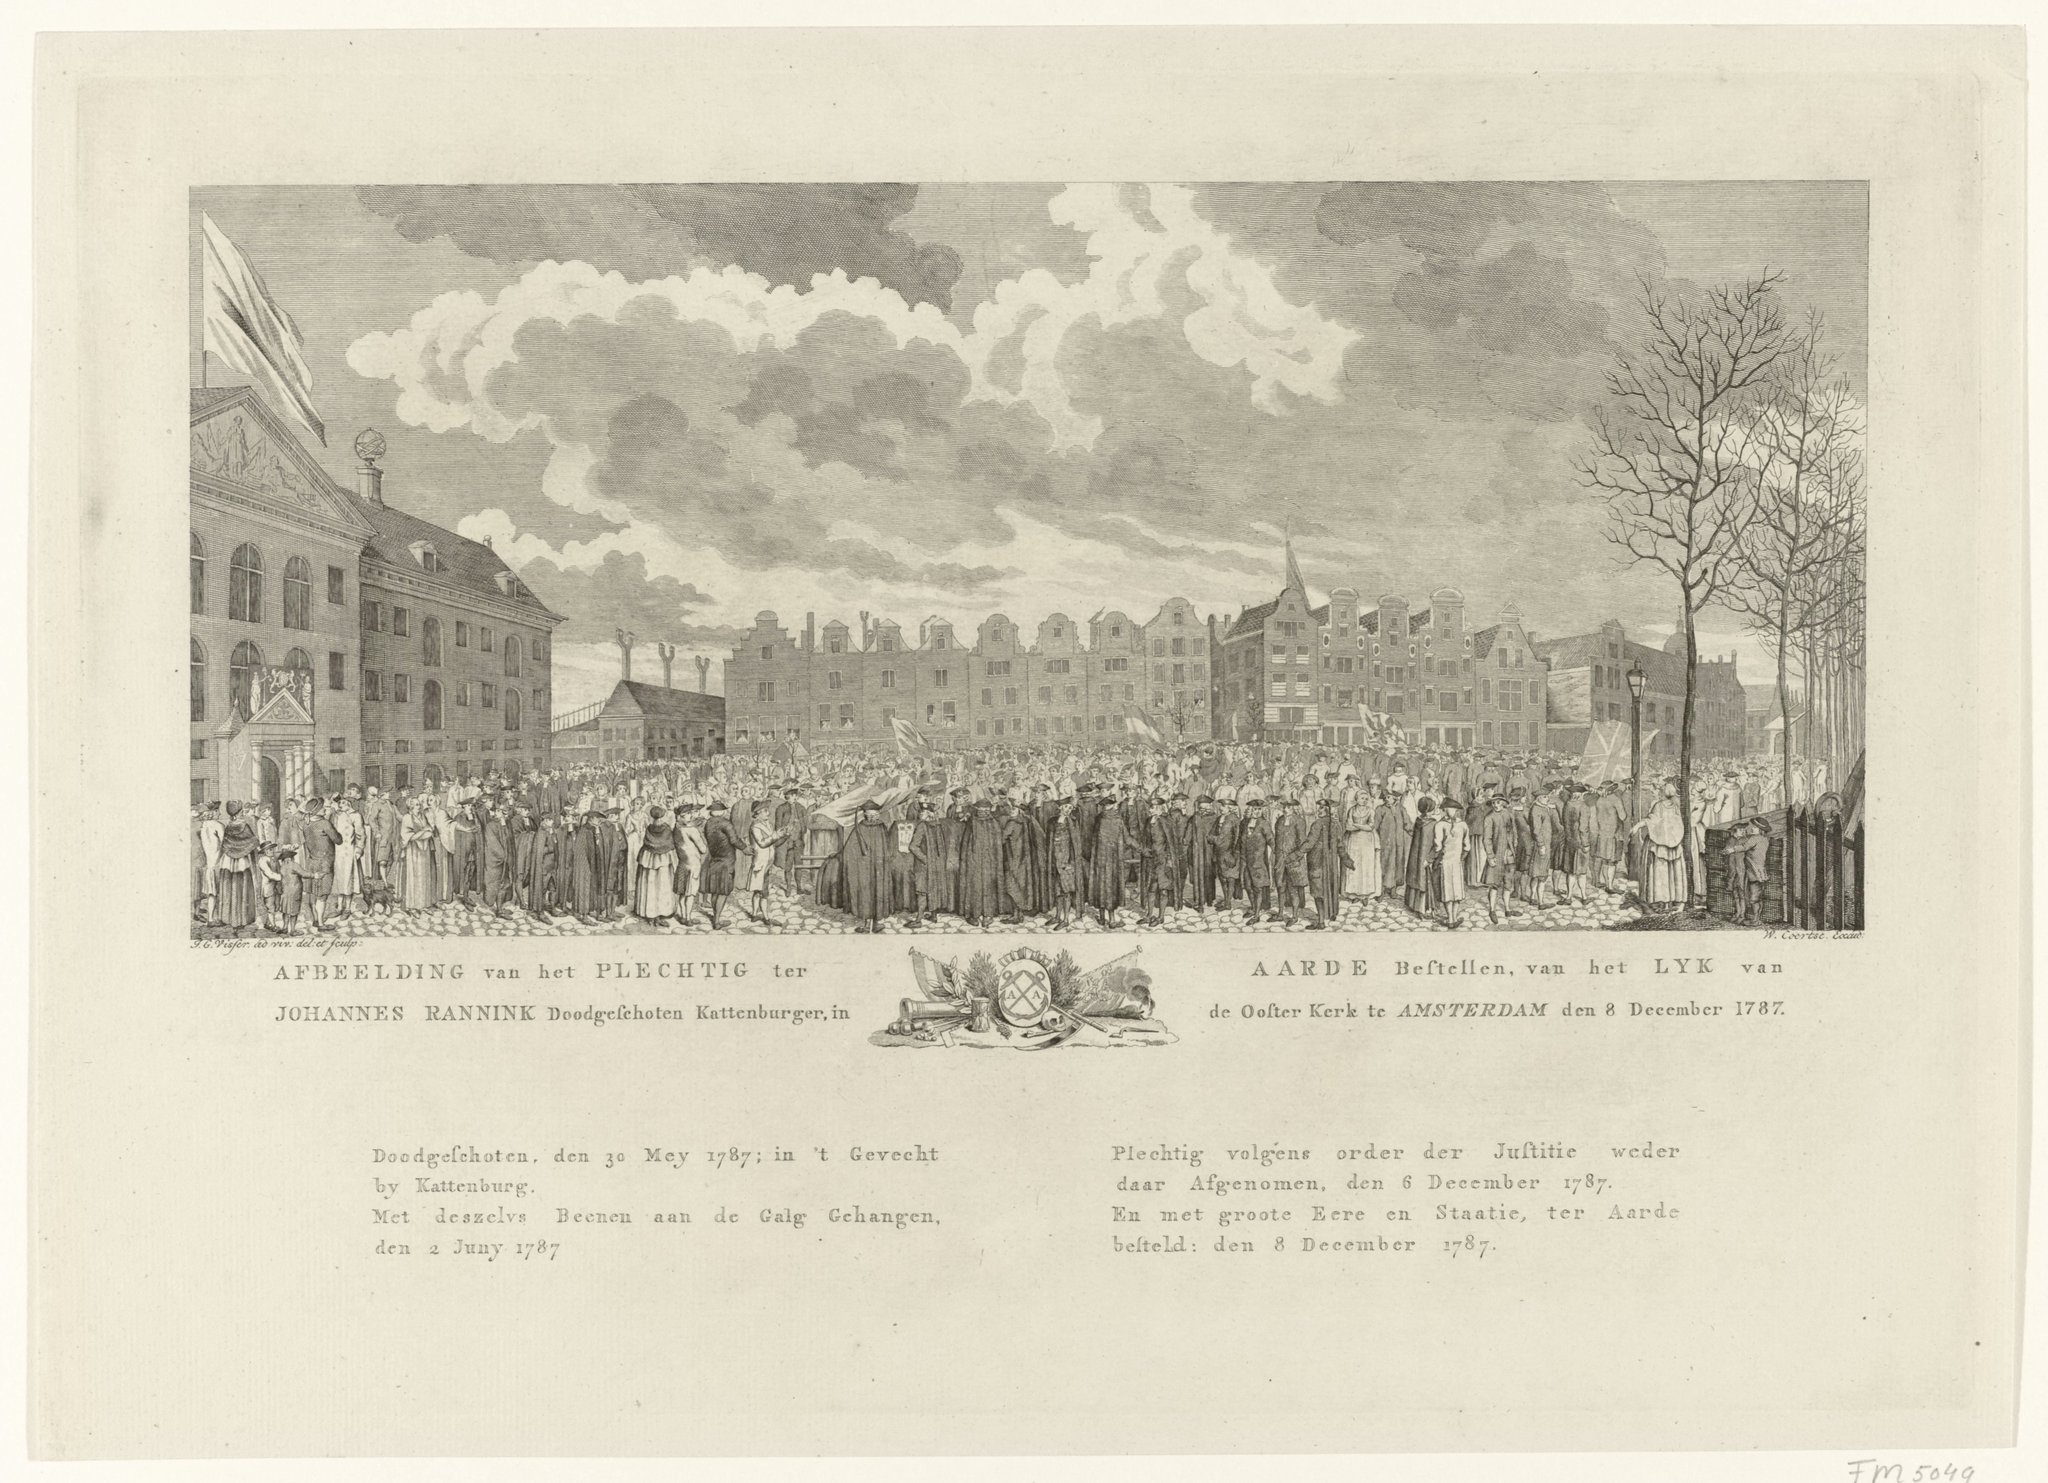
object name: print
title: Afbeelding van het Plechtig ter Aarde Bestellen, van het Lyk van Johannes Rannink Doodgeschoten Kattenburger, in de Ooster Kerk te Amsterdam den 8 December 1787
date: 1787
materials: paper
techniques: engraving, etching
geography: amsterdam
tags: cortege, funeral procession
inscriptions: collector's mark: Lugt 2228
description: Begrafenis van Johannes Rannink, aanvoerder van de bijltjes, de opstandige Oranjegezinde Amsterdamse scheepstimmerlieden die op het eiland Kattenburg in opstand kwamen tegen het patriotse stadsbestuur, en die sneuvelde op 30 mei 1787. Volgens het onderschrift was het lichaam van Rannink aan de benen aan de galg gehangen op 2 juni, op 6 december afgenomen en op 8 december plechtig herbegraven. Gezicht op de begrafenisstoet op het Kattenburgerplein. In het publiek Nederlandse, Pruisische en Britse vlaggen. Onder de voorstelling het wapen van de Admiraliteit van Amsterdam. Zie pendant.